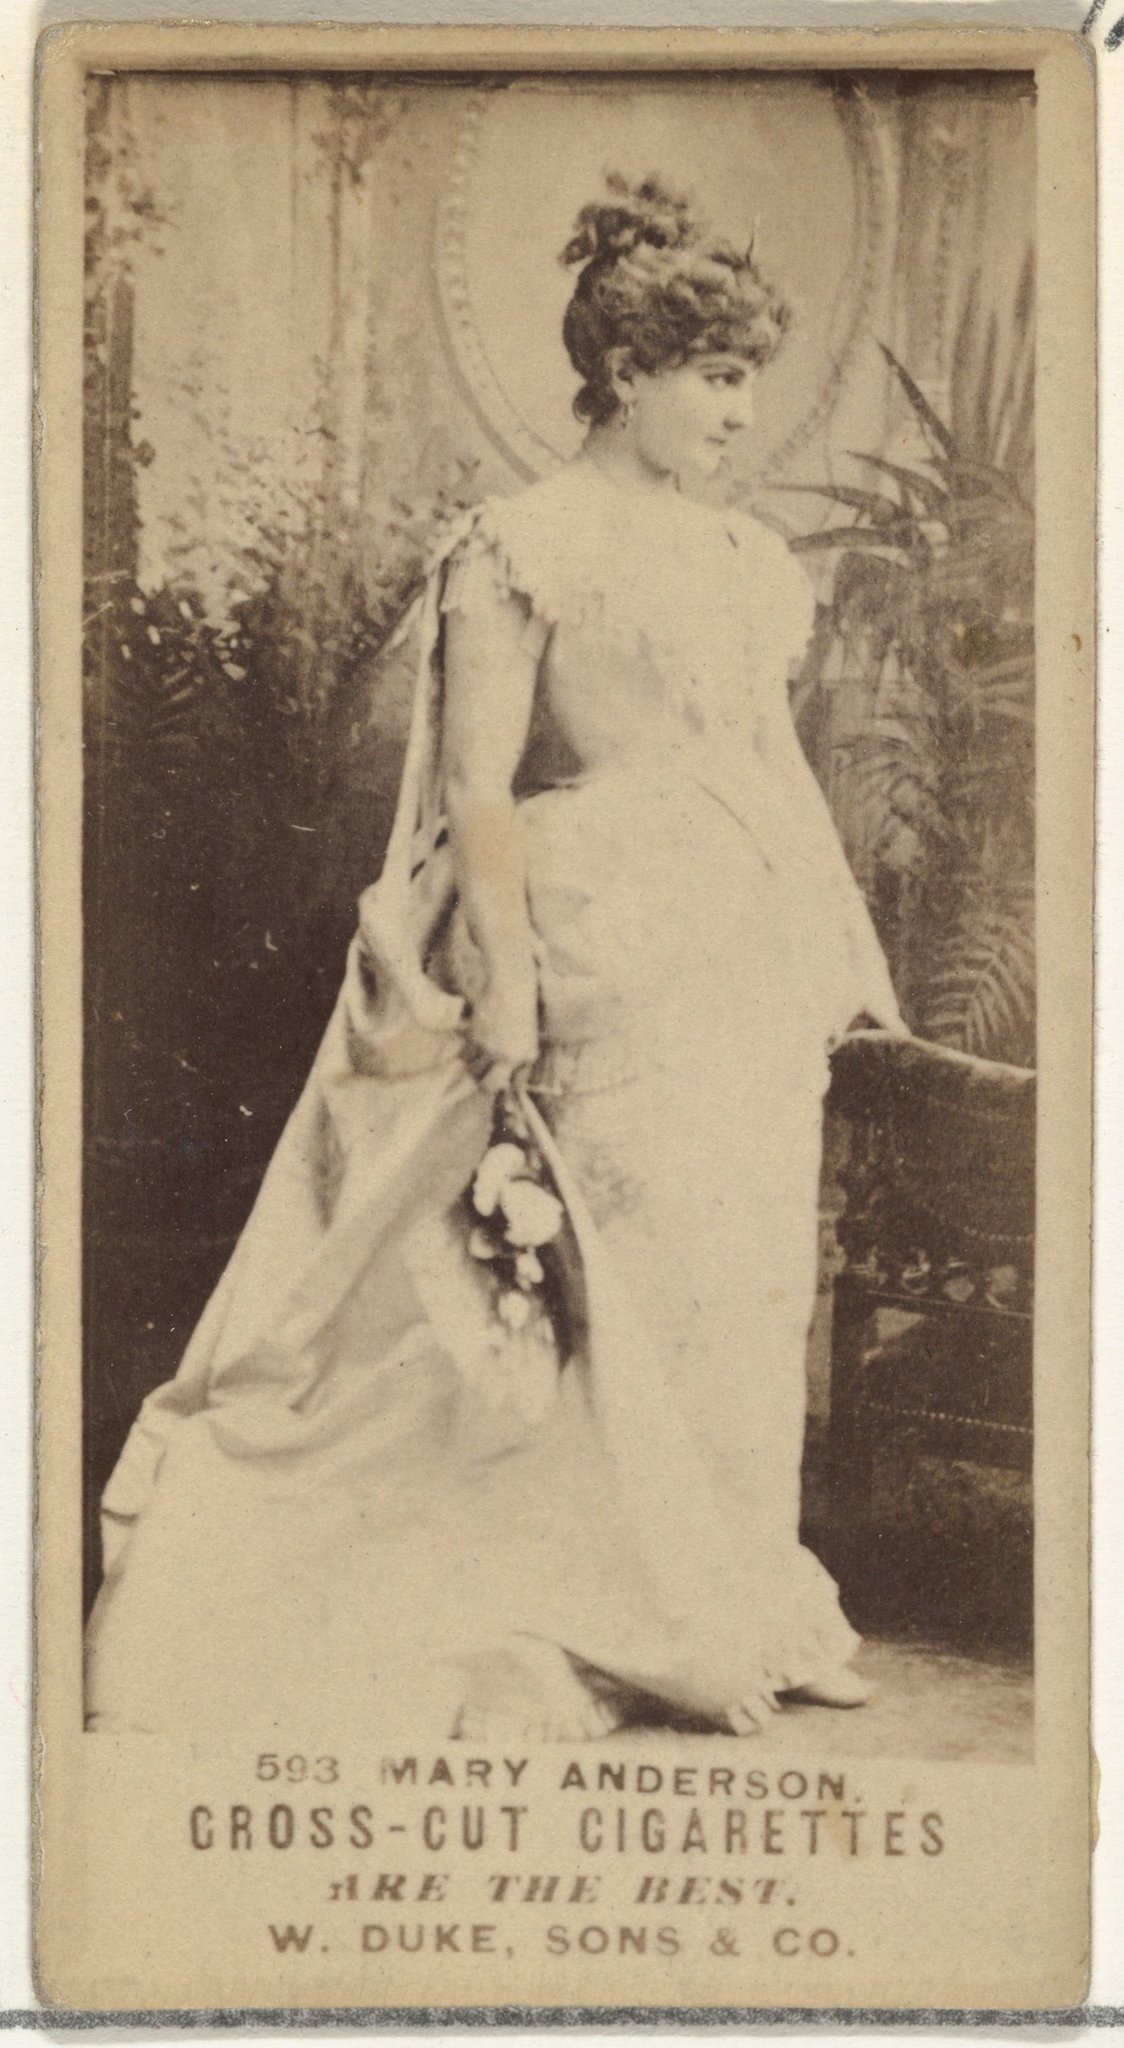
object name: photograph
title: Card Number 593, Mary Anderson, from the Actors and Actresses series (N145-3) issued by Duke Sons & Co. to promote Cross Cut Cigarettes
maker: w. duke, sons & co.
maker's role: publisher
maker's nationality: american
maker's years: 1870-1920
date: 1880-1889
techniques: albumen silver print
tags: women,actresses